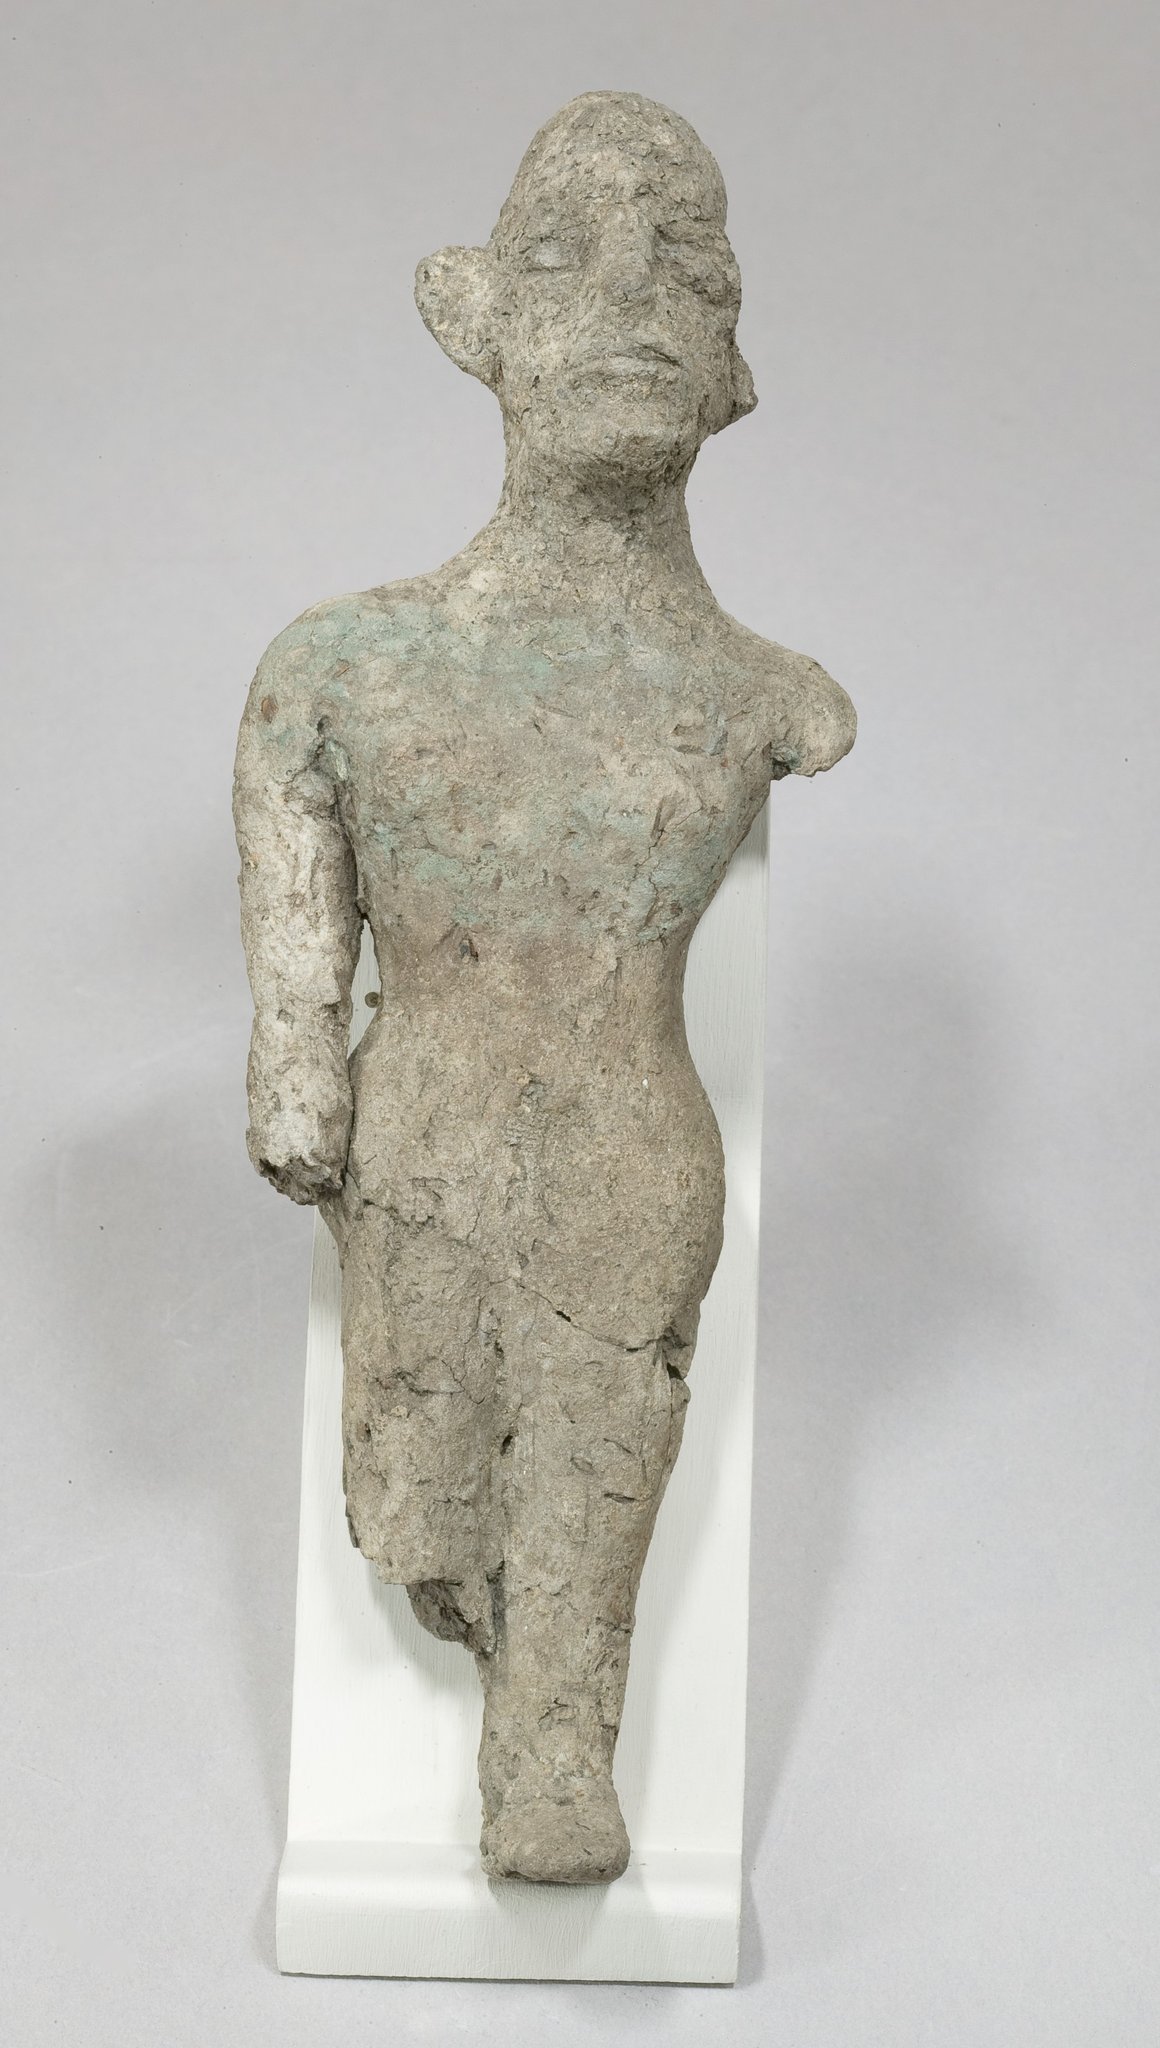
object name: statuette, king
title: Statuette of king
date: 1981-1640 BCE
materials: clay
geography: egypt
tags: kings